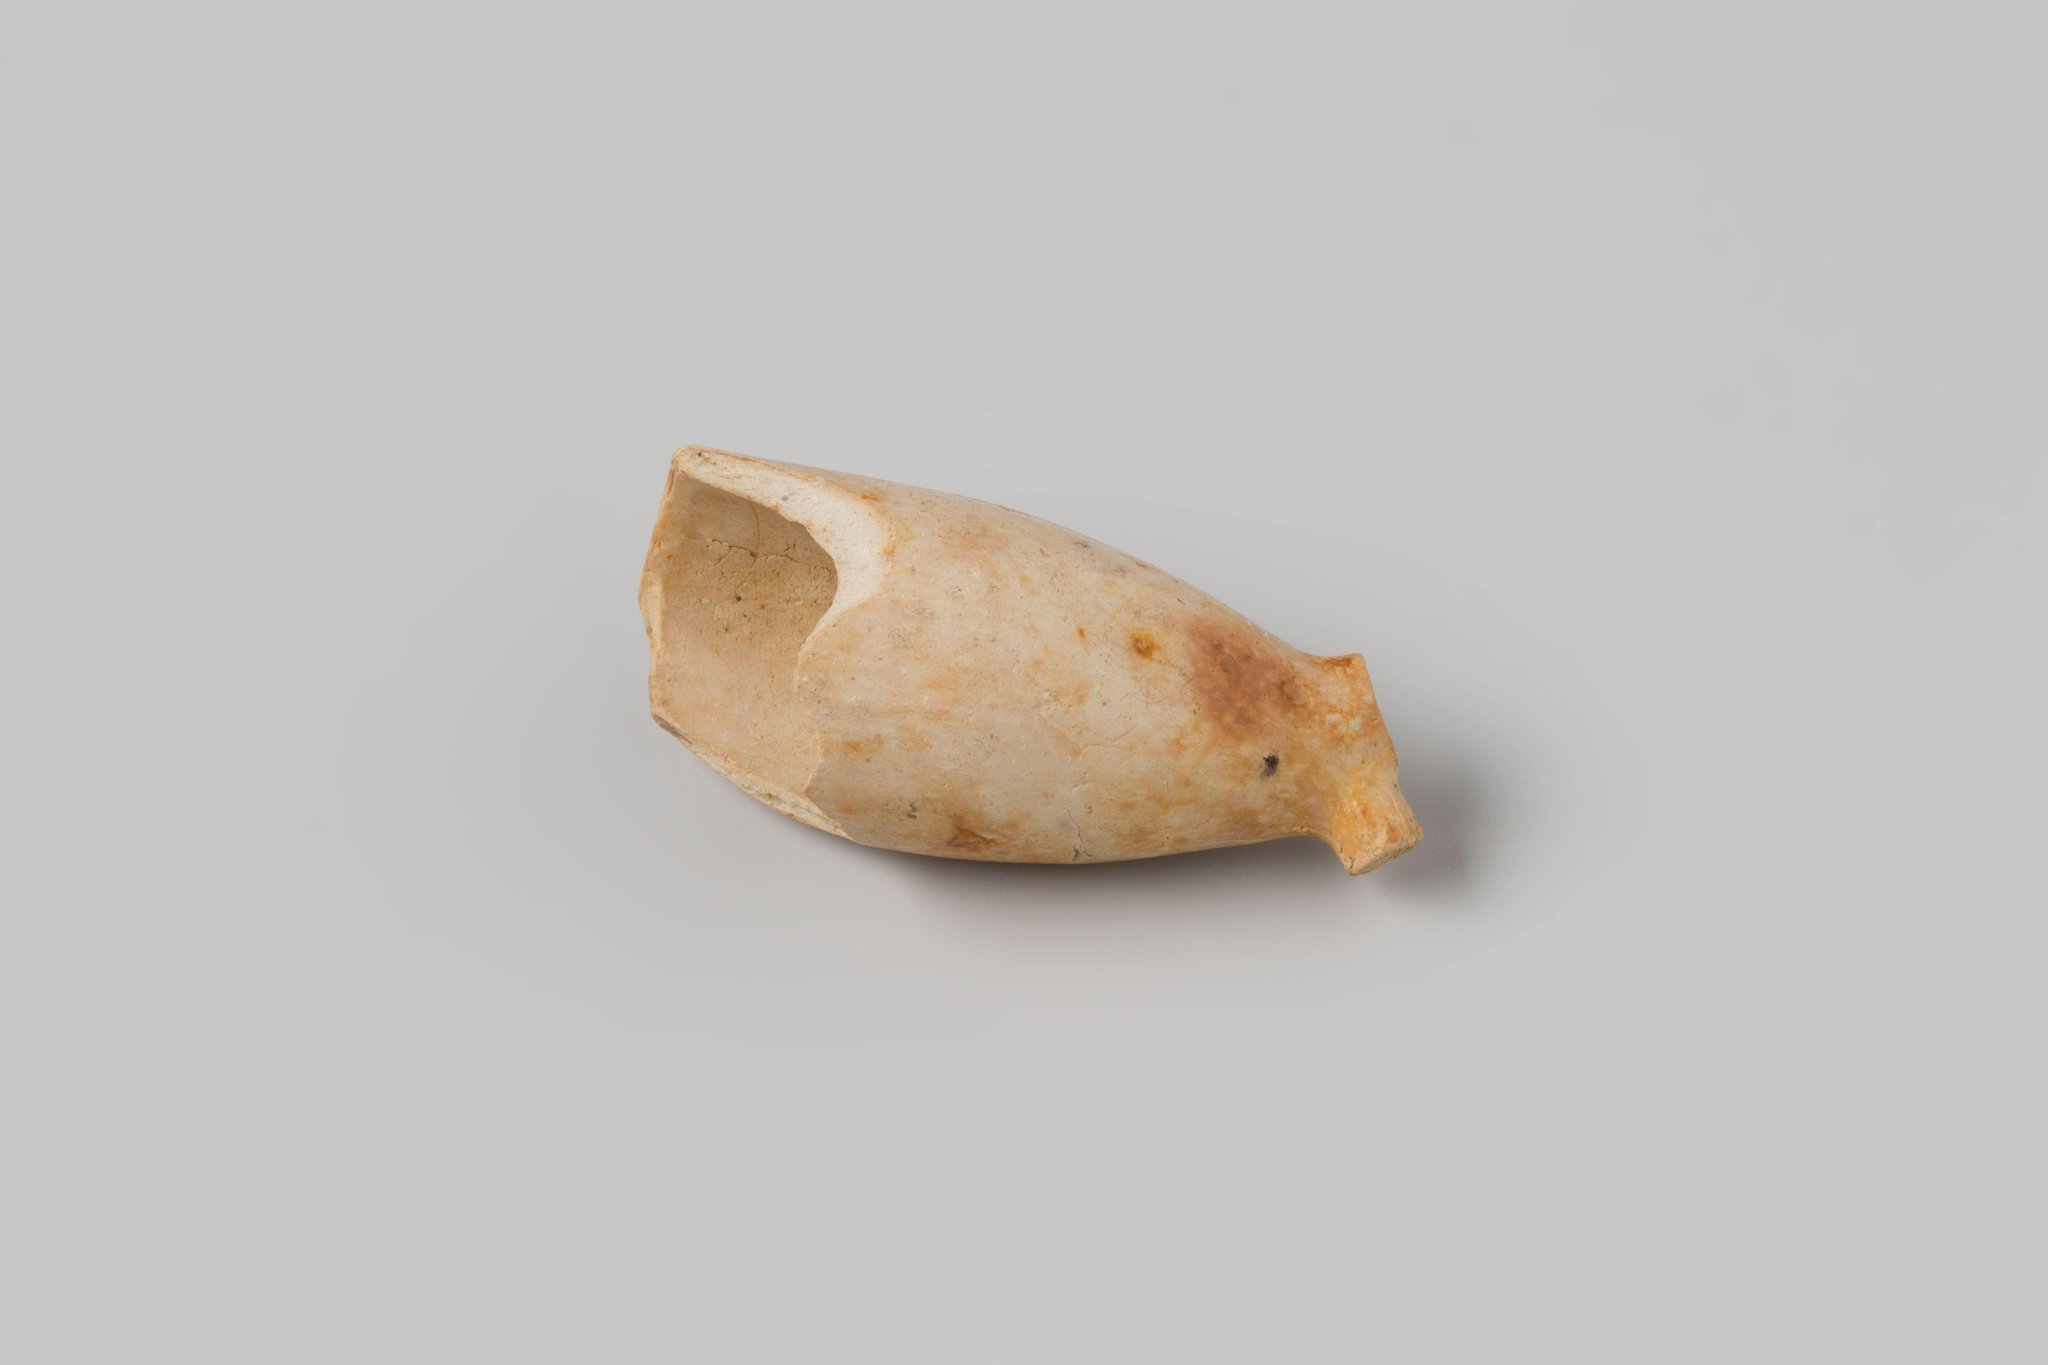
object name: pipe bowl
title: Fragment pijpenkop uit het wrak van de Oost-Indiëvaarder Hollandia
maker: Anonymous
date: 1700-1743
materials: clay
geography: netherlands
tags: verenigde oostindische compagnie, hollandia (schip), annet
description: Pipe, bowl, heelmark: crowned 47; fragment, 2hsm3.